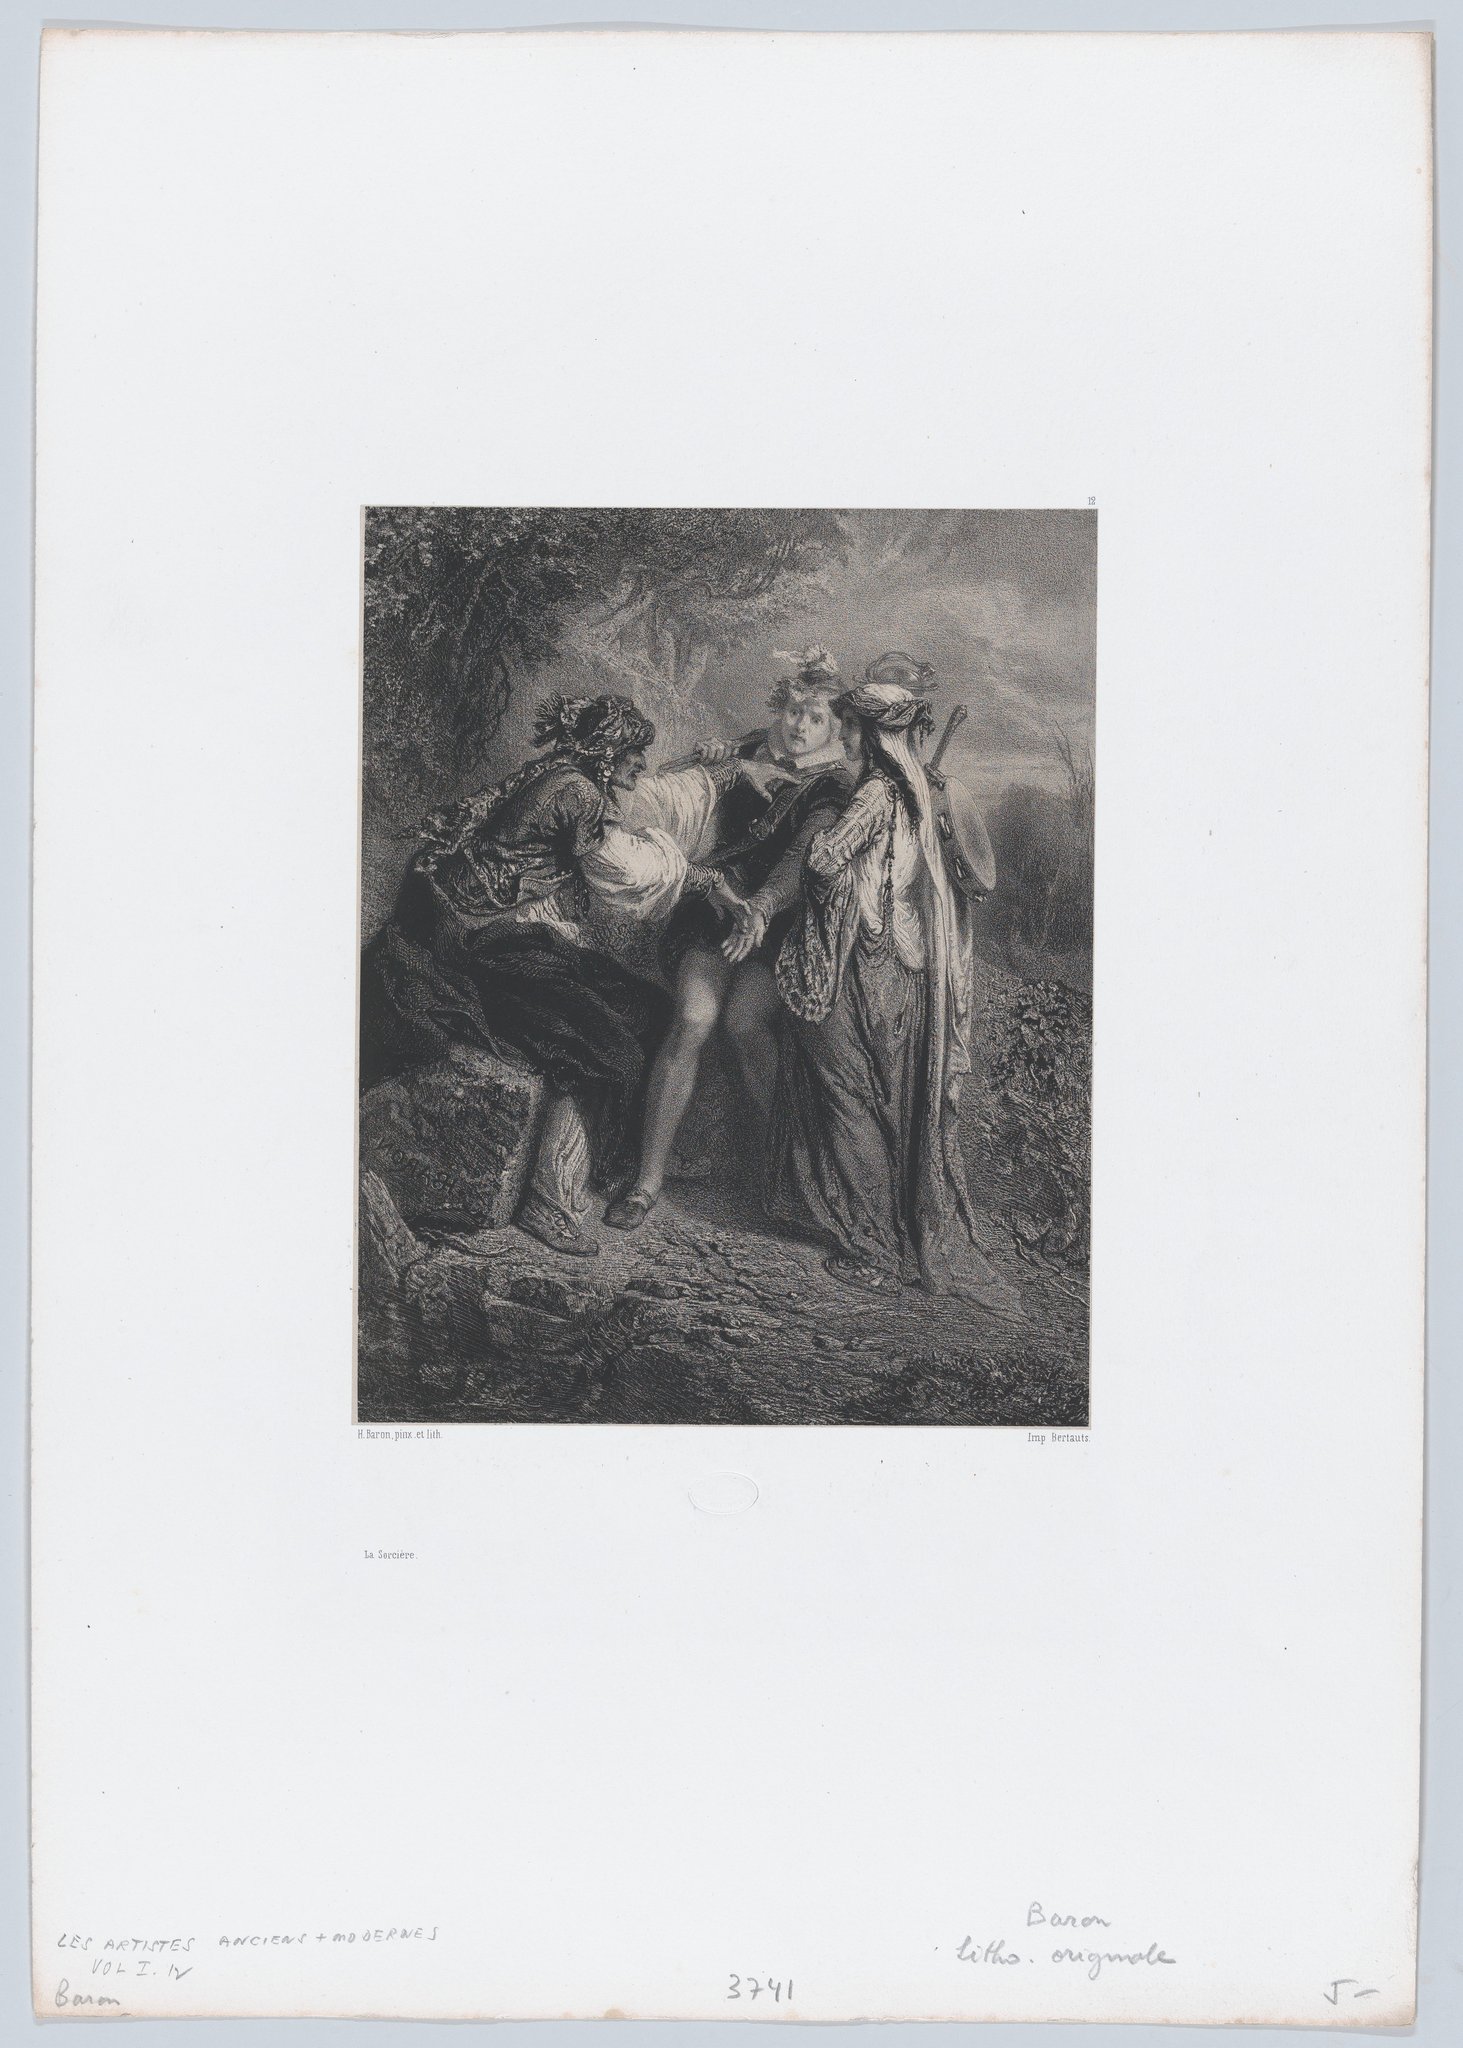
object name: print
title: The Witch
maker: henri-charles-antoine baron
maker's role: artist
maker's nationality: french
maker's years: 1816-1885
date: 1850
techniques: lithograph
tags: men,women,witches